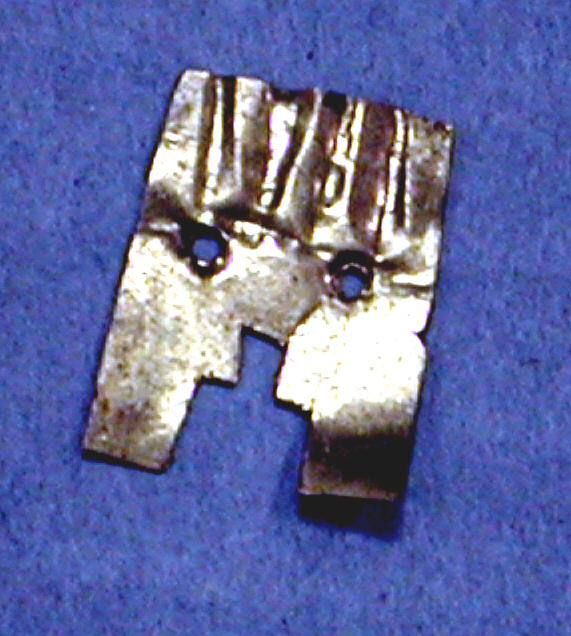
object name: ornament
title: Hammered Gold Ornament Fragment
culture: peruvian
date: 900-1470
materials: gold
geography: peru